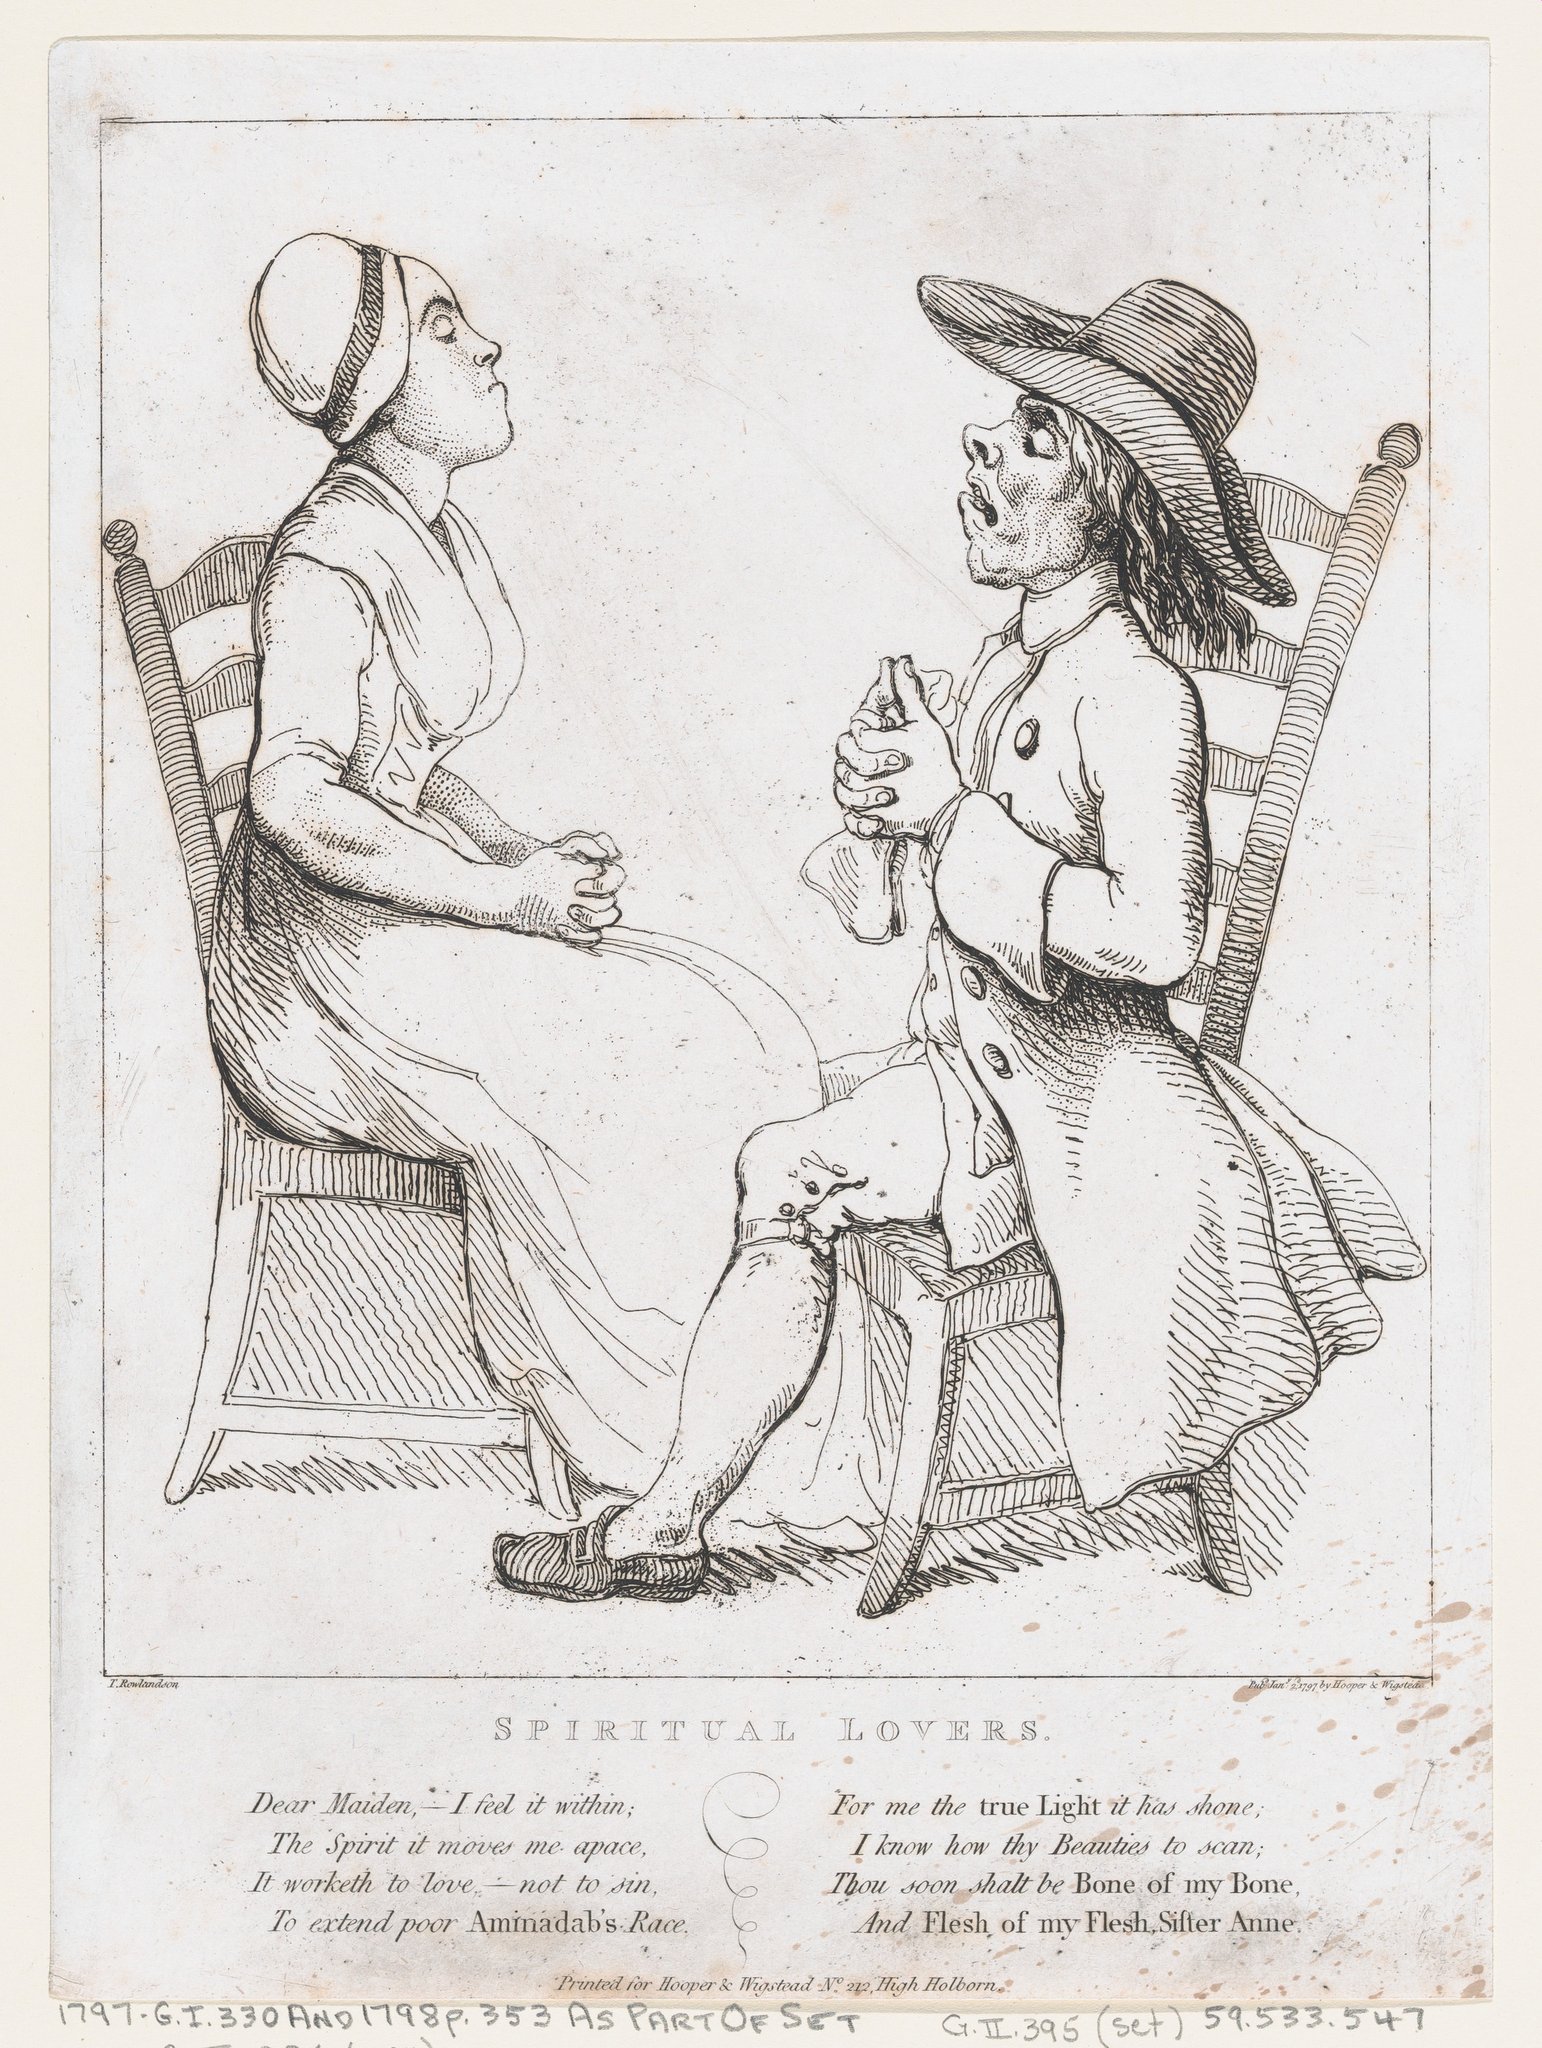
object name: print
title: Spiritual Lovers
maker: thomas rowlandson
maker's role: artist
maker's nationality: british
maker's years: 1757-1827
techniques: etching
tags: men,lovers,women